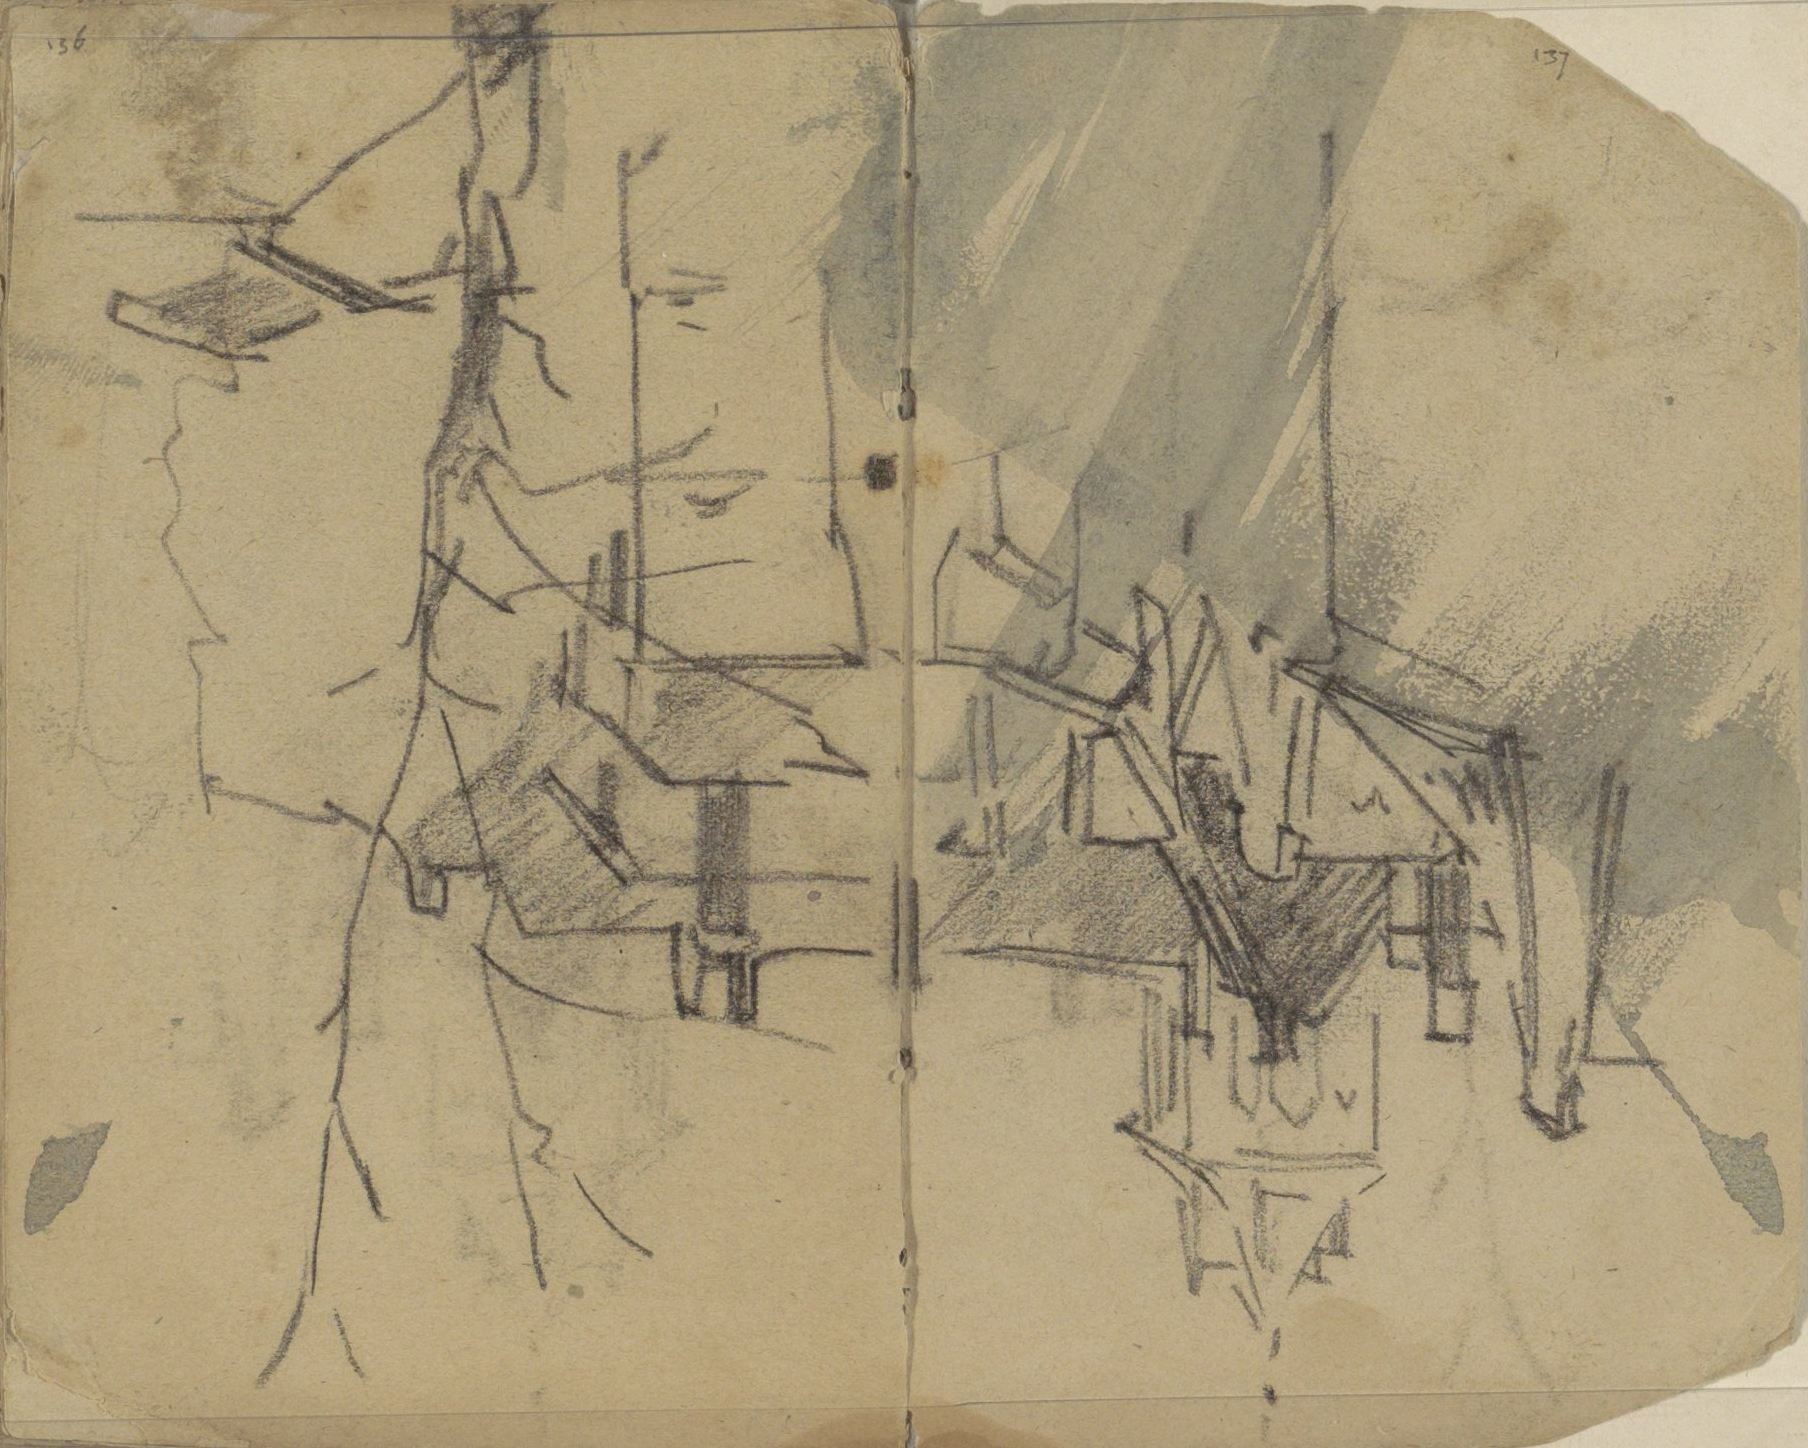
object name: sketchbook leaf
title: Gezicht op Delft met het stadhuis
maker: george hendrik breitner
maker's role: draughtsman, painter, print maker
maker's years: 1857-1923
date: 1881-1883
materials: chalk, paper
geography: delft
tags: urban housing, city-view, and landscape with man-made constructions, tower (of house or building)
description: Gezicht op Delft met de toren van het stadhuis. Pagina 136 en pagina 137 uit een schetsboek met 70 bladen.